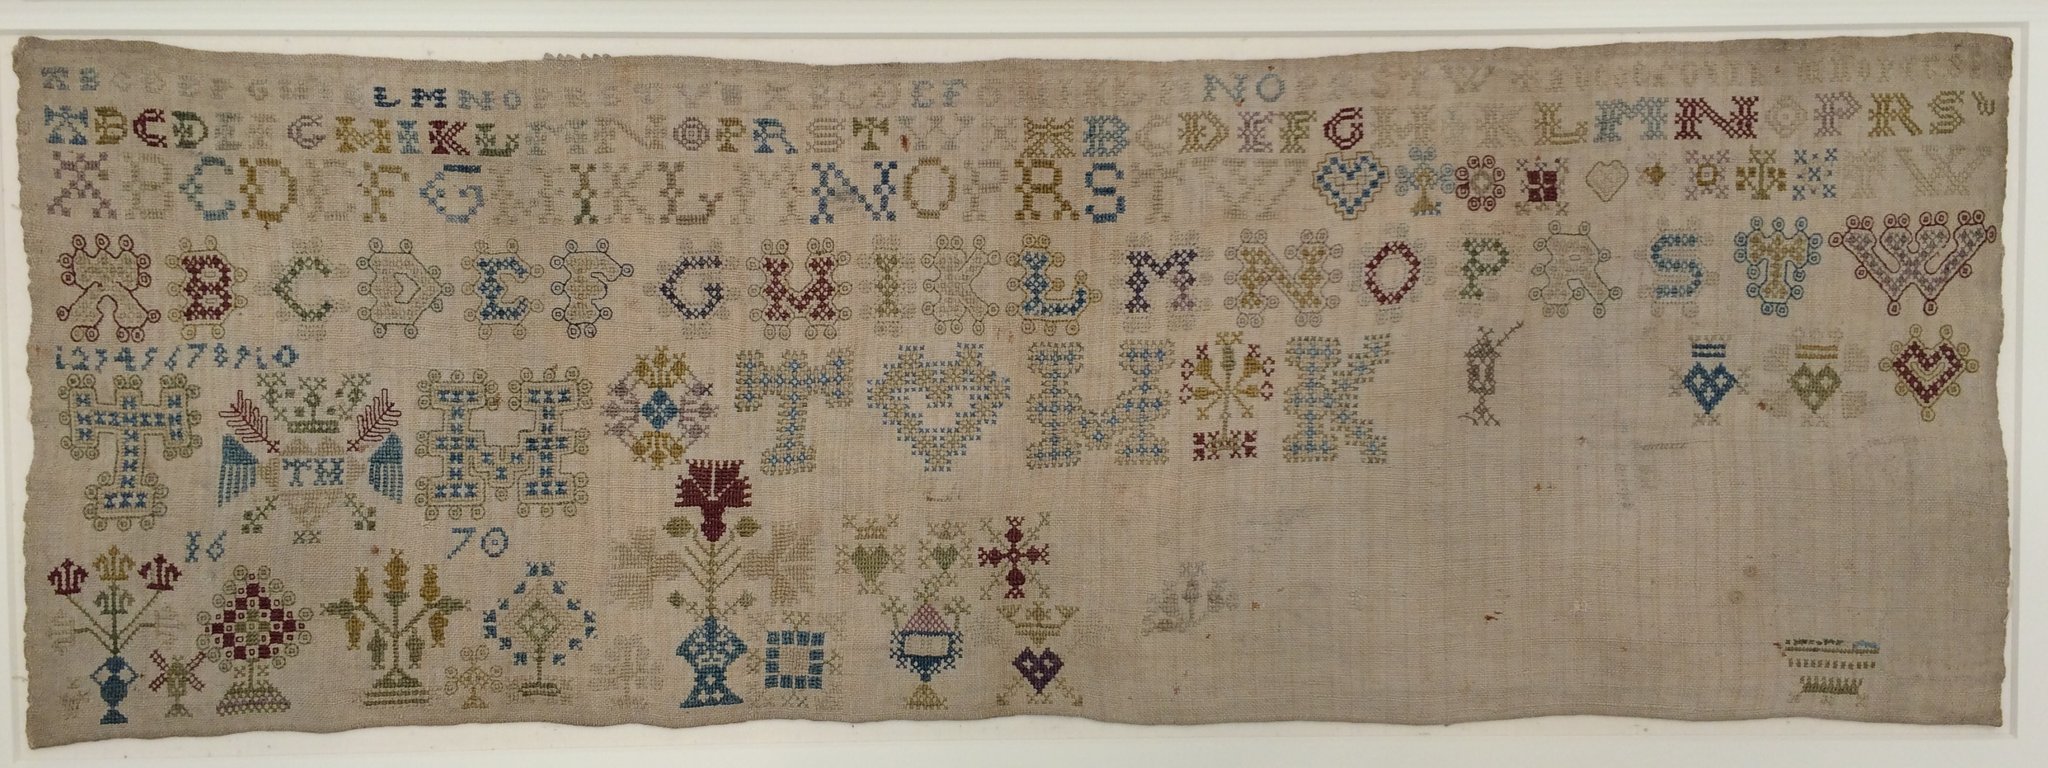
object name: sampler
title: Embroidered sampler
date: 1670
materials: linen, silk